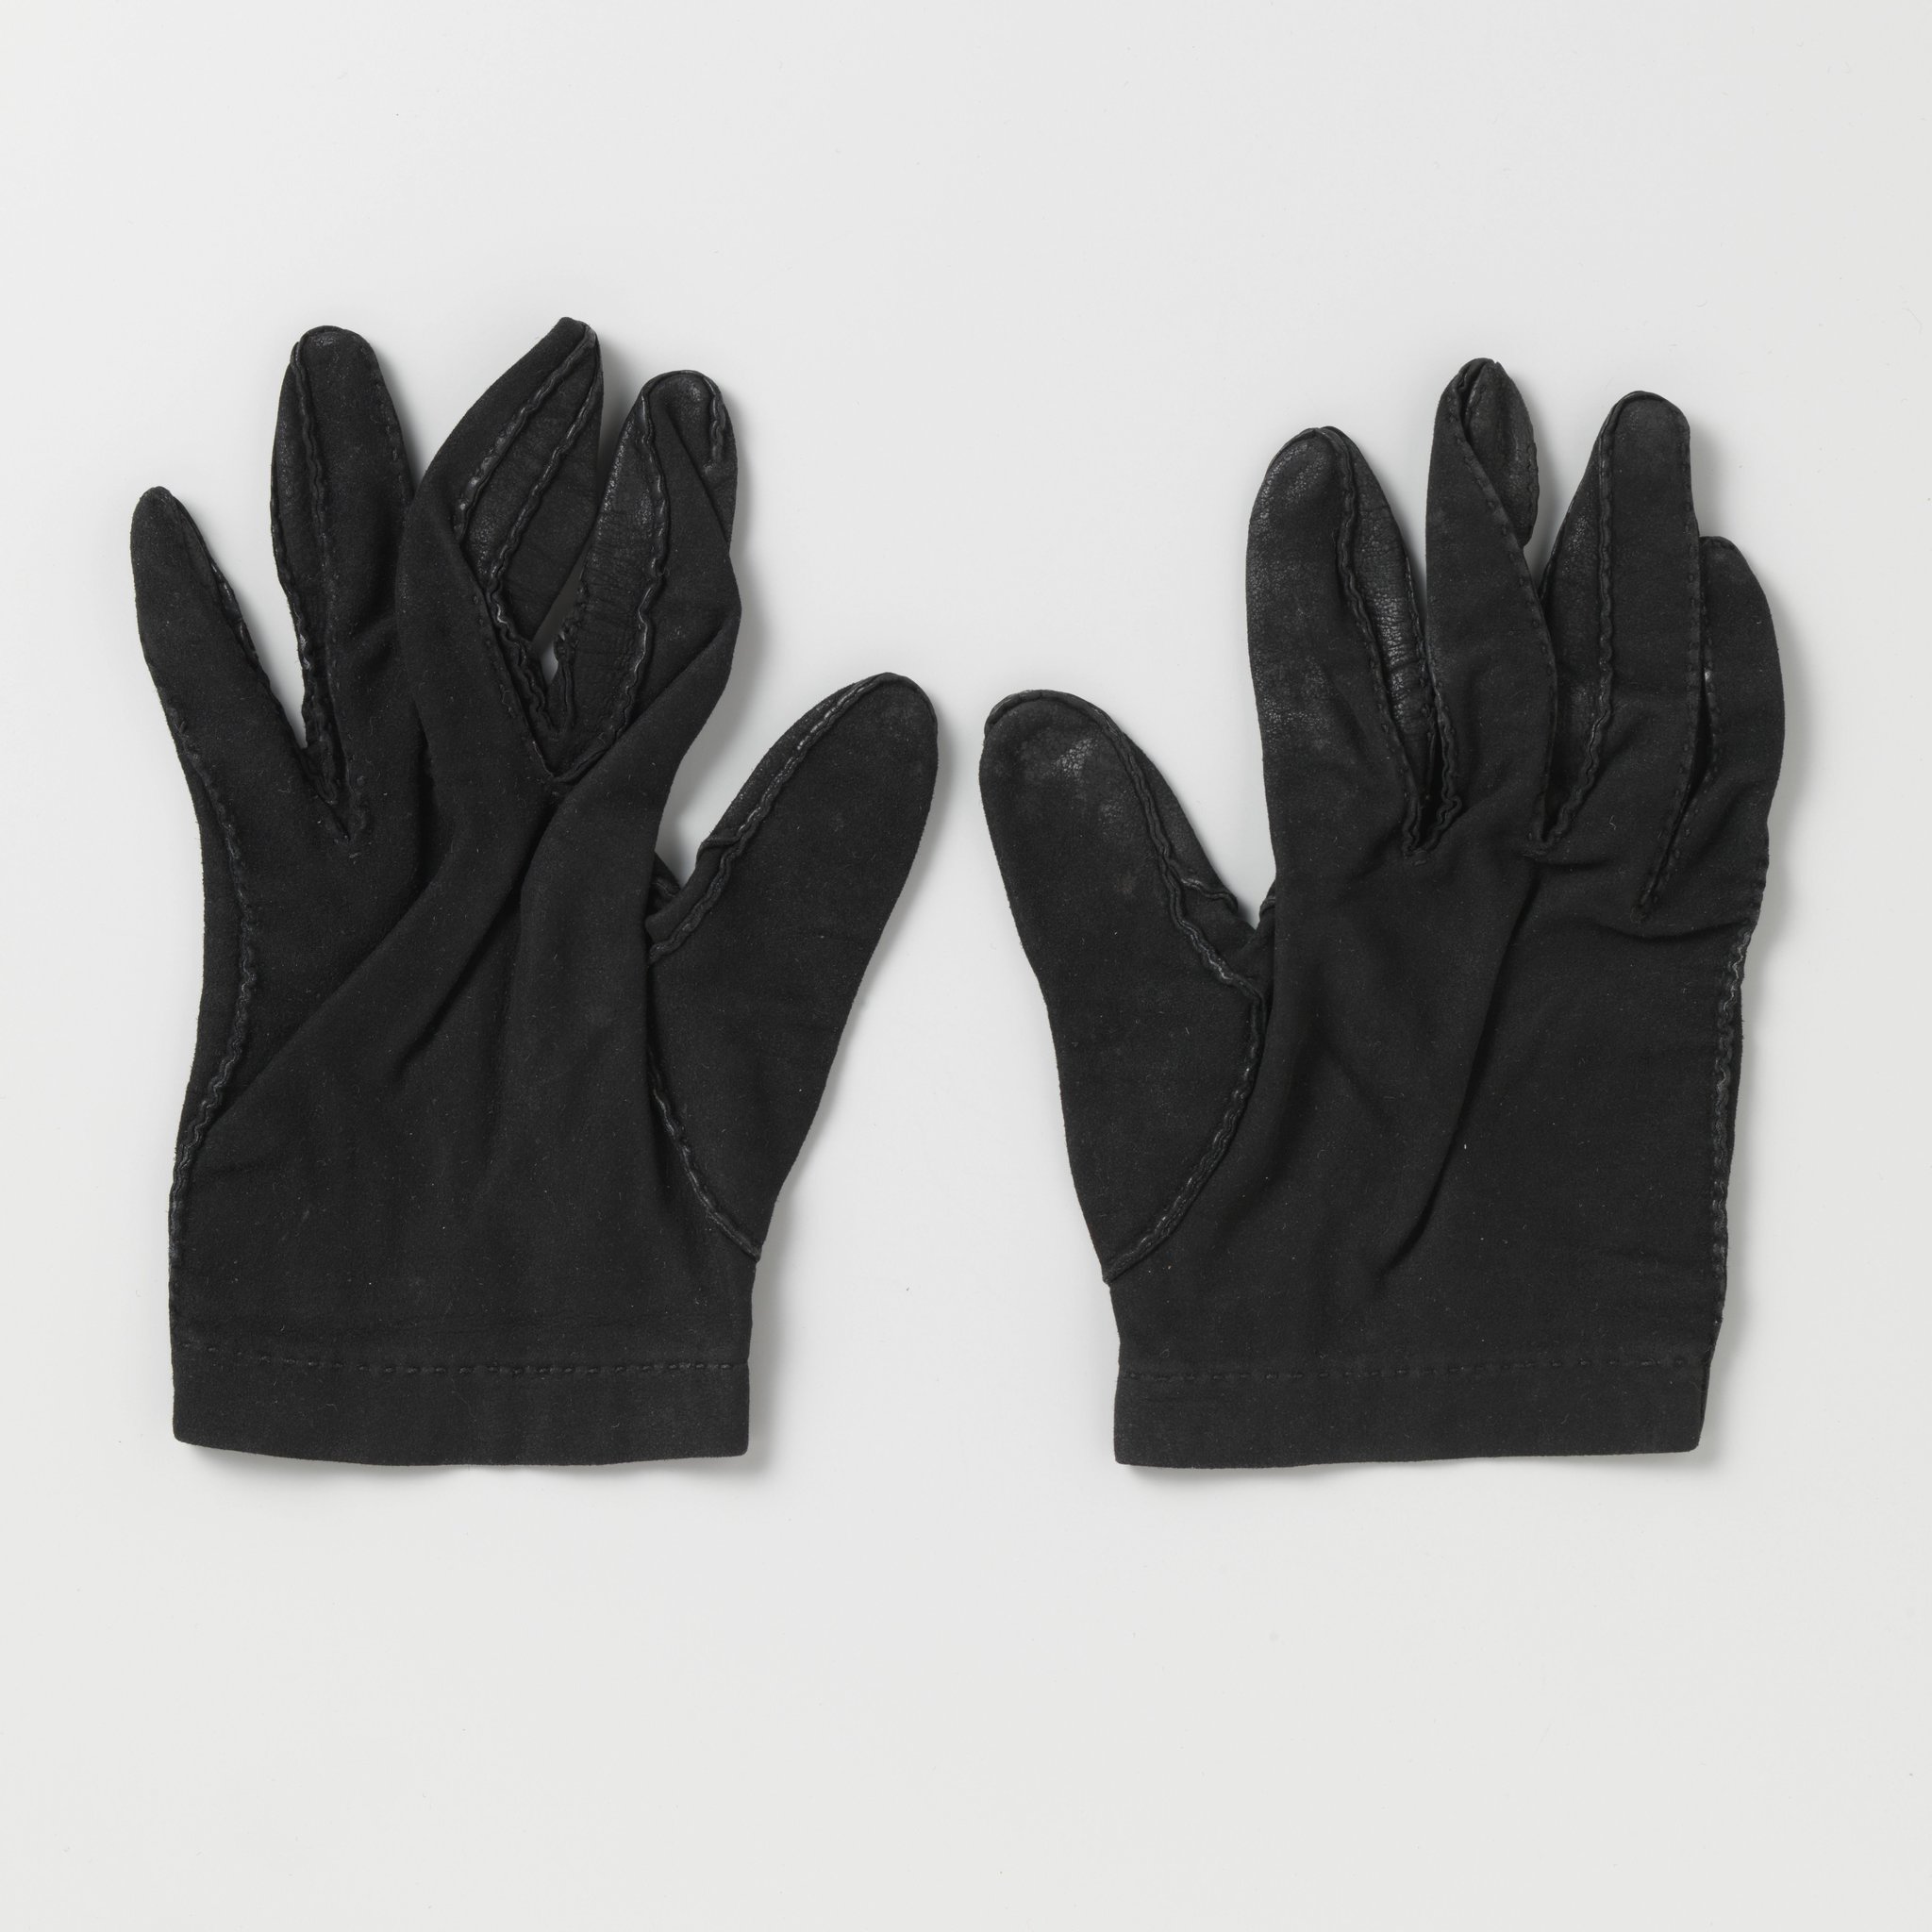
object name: glove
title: Linker handschoen van zwarte suede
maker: Anonymous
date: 1900-1915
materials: leather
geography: netherlands